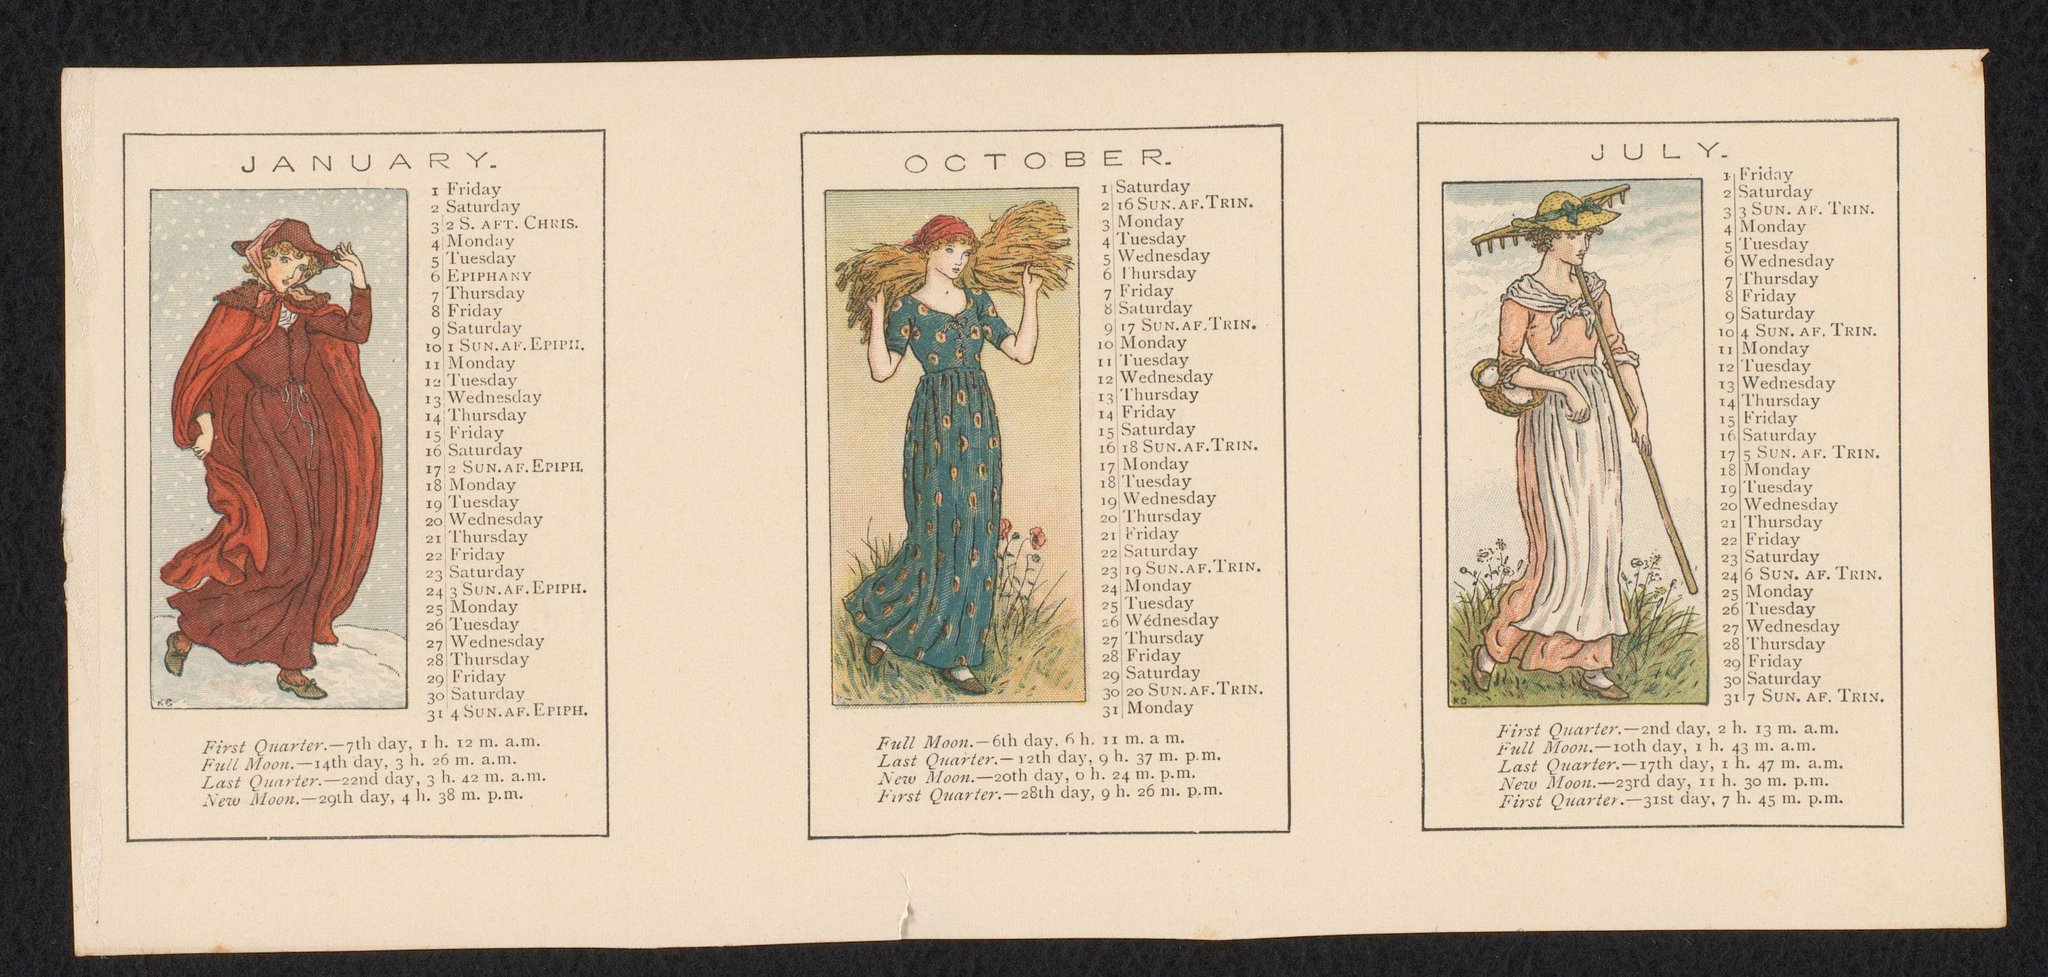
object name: print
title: Zes proefdrukken voor 'Kate Greenaway's Almanack for 1892'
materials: paper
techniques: wood engraving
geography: london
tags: harvest, the twelve months represented by scenes showing human activities, usually in a landscape; so-called 'labours of the months'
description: Proefdrukken van zes van de bladzijden uit de almanak, de maanden januari, februari, juli, augustus, september en oktober. Voor elk van de maanden een vrouwenfiguur dat symbool staat voor die maand.